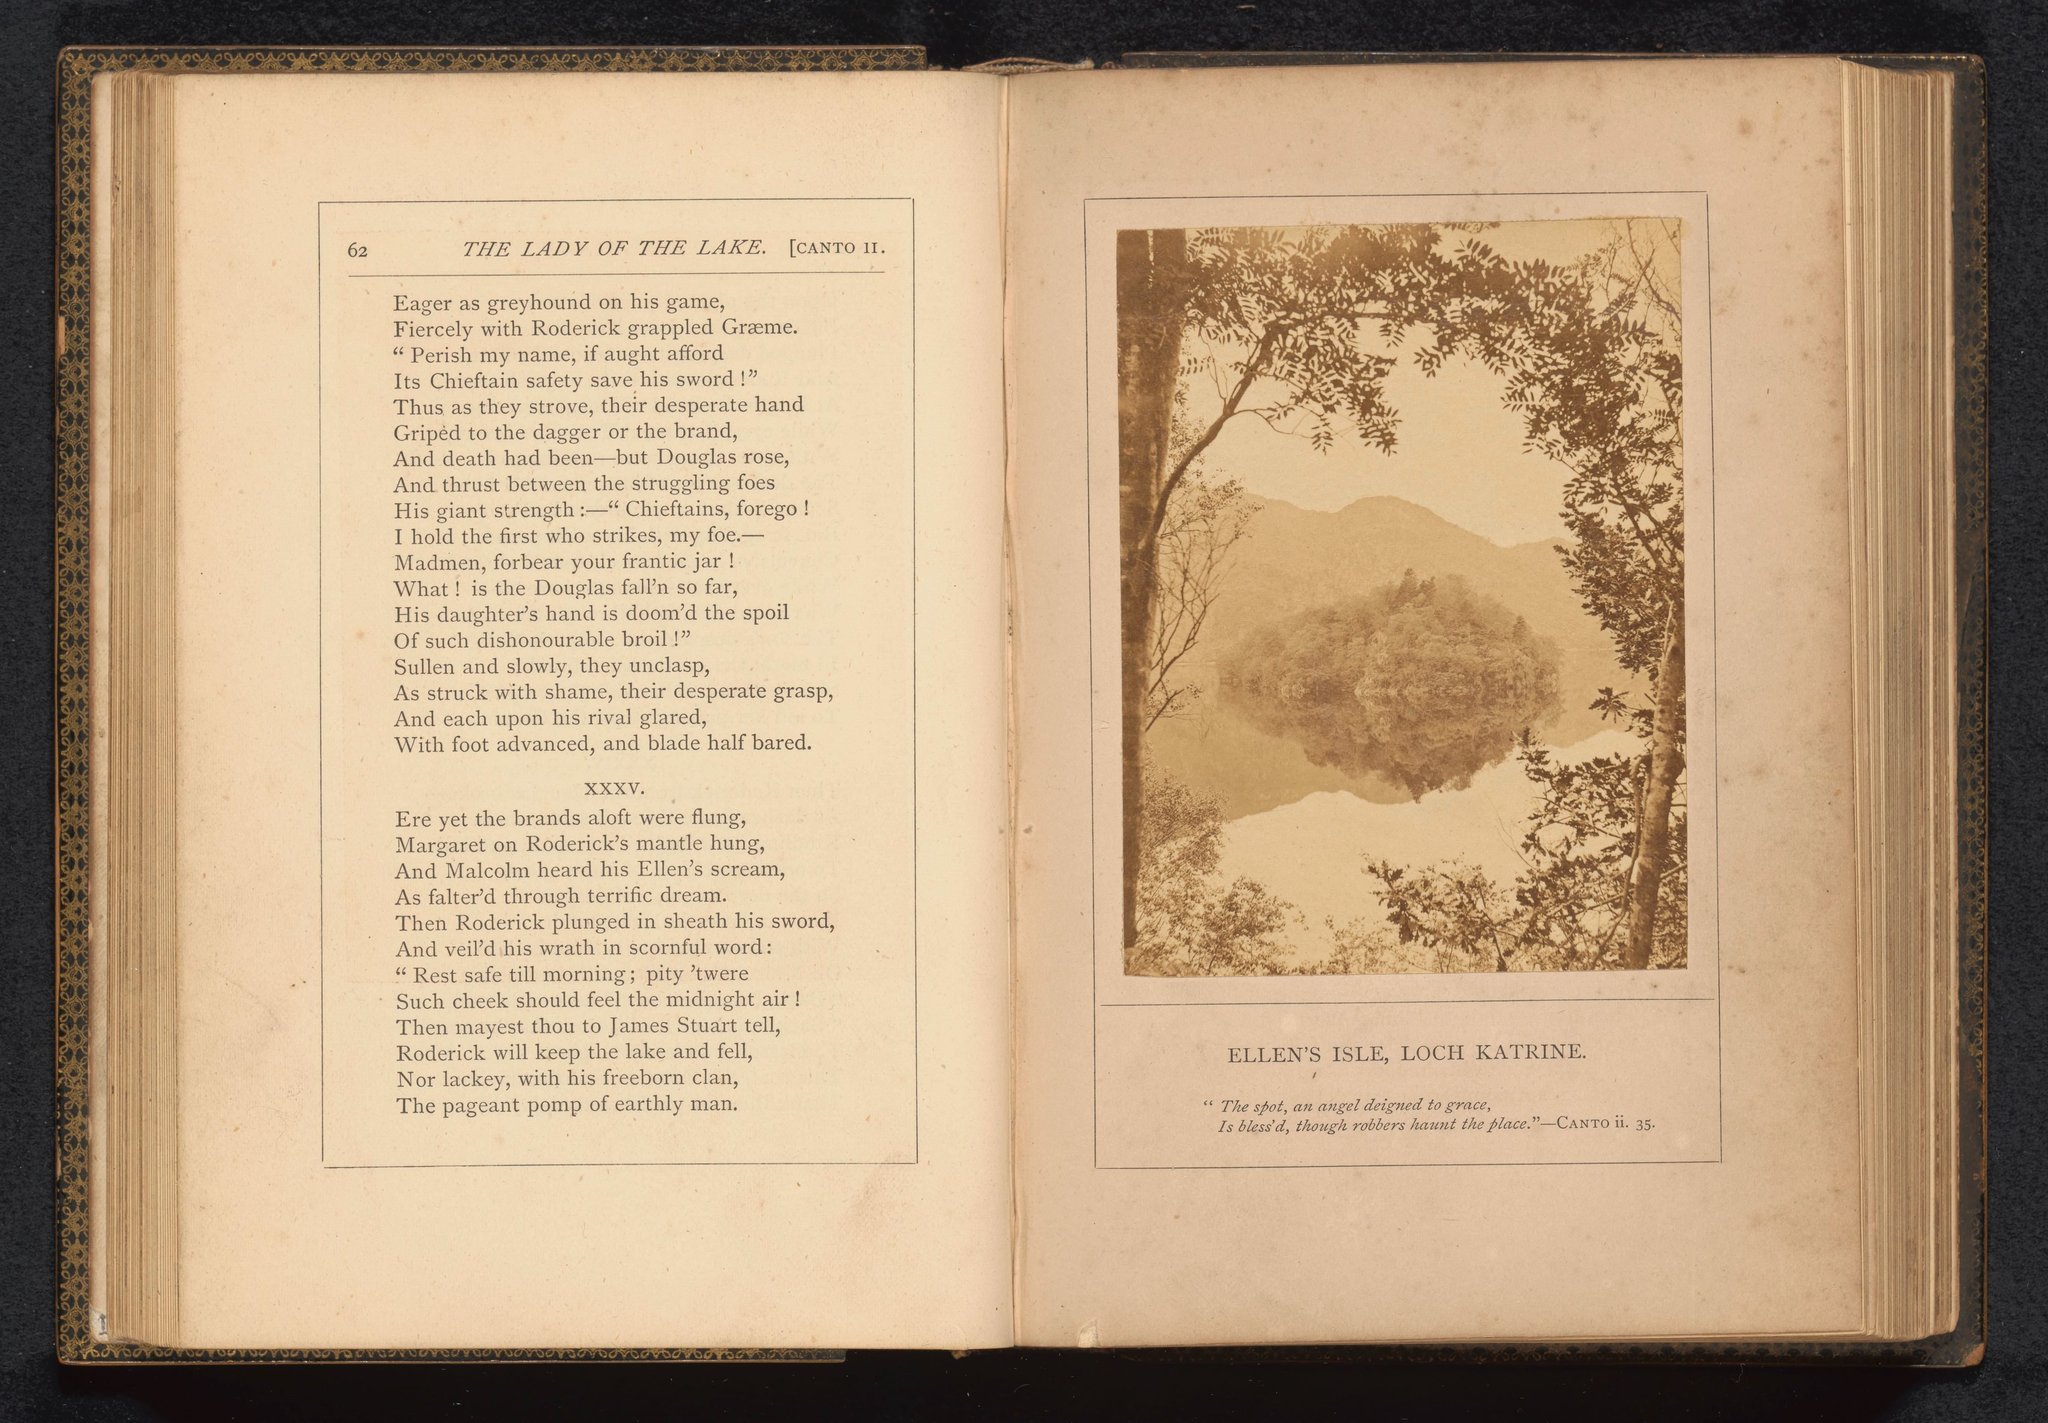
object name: page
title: Gezicht op Ellen's Isle in Loch Katrine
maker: Anonymous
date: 1861-1871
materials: photographic support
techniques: albumen print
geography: loch katrine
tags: island, lake, mountains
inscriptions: inscription: ‘“The spot, an angel deigned to grace, is bless'd, though robbers haunt the place.” - Canto ii. 35.’